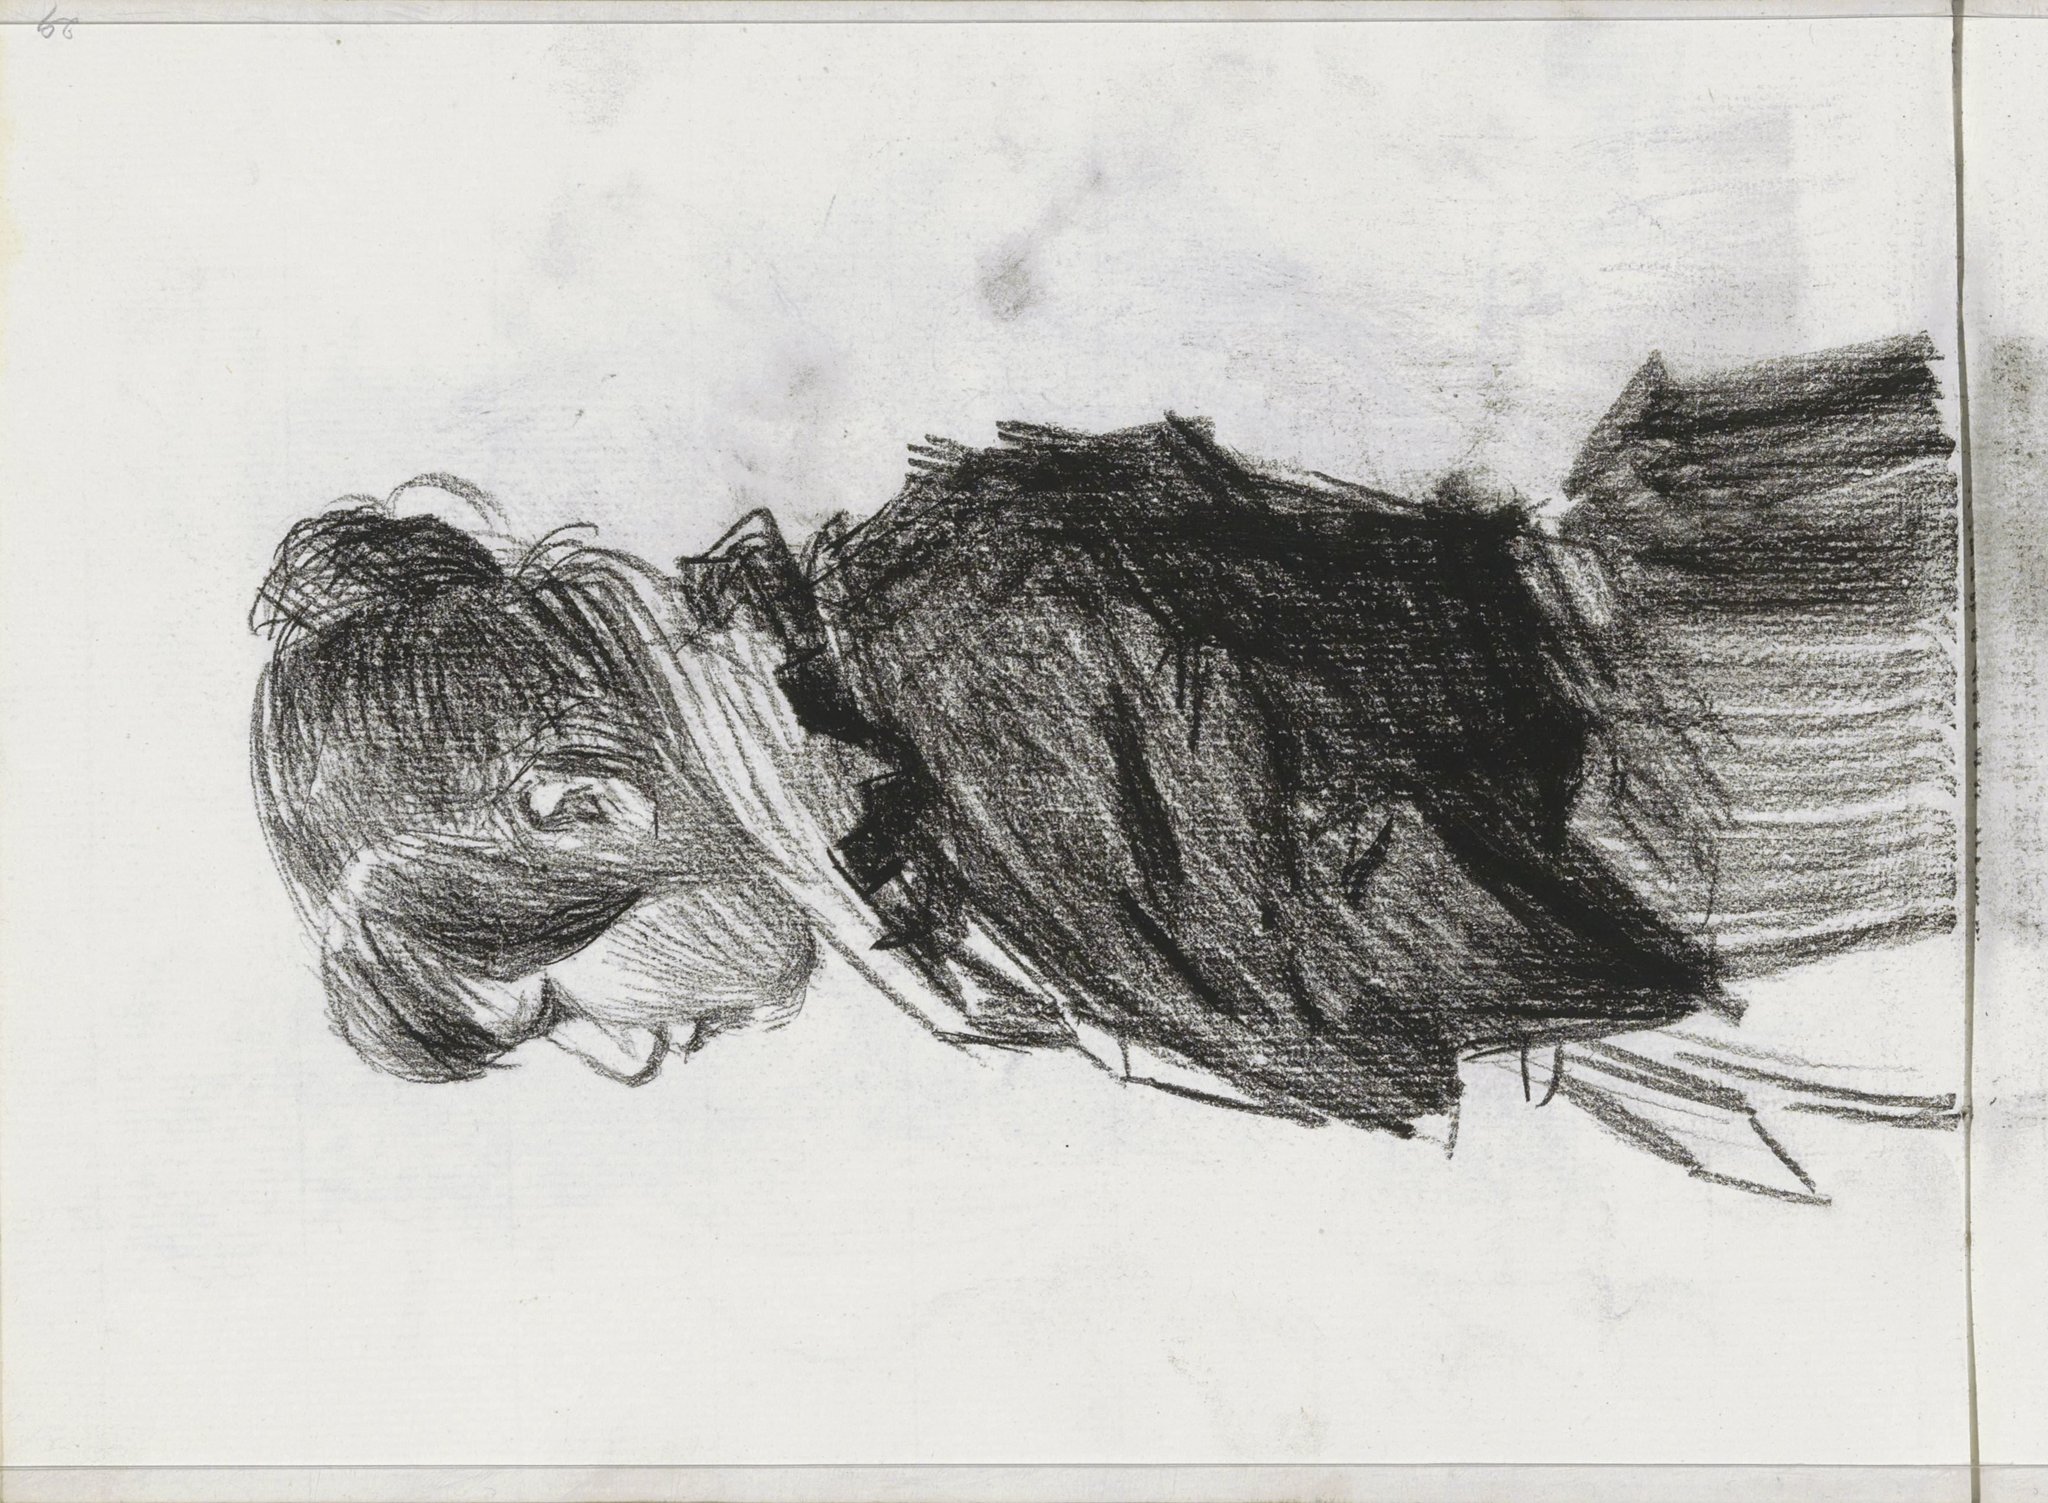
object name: sketchbook leaf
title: Staande jonge vrouw, in profiel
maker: isaac israels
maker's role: draughtsman, painter, print maker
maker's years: 1865-1934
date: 1875-1934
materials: chalk, paper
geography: amsterdam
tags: adolescent, young woman, maiden (+ standing)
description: Blad 22 verso uit schetsboek XX met 26 bladen.